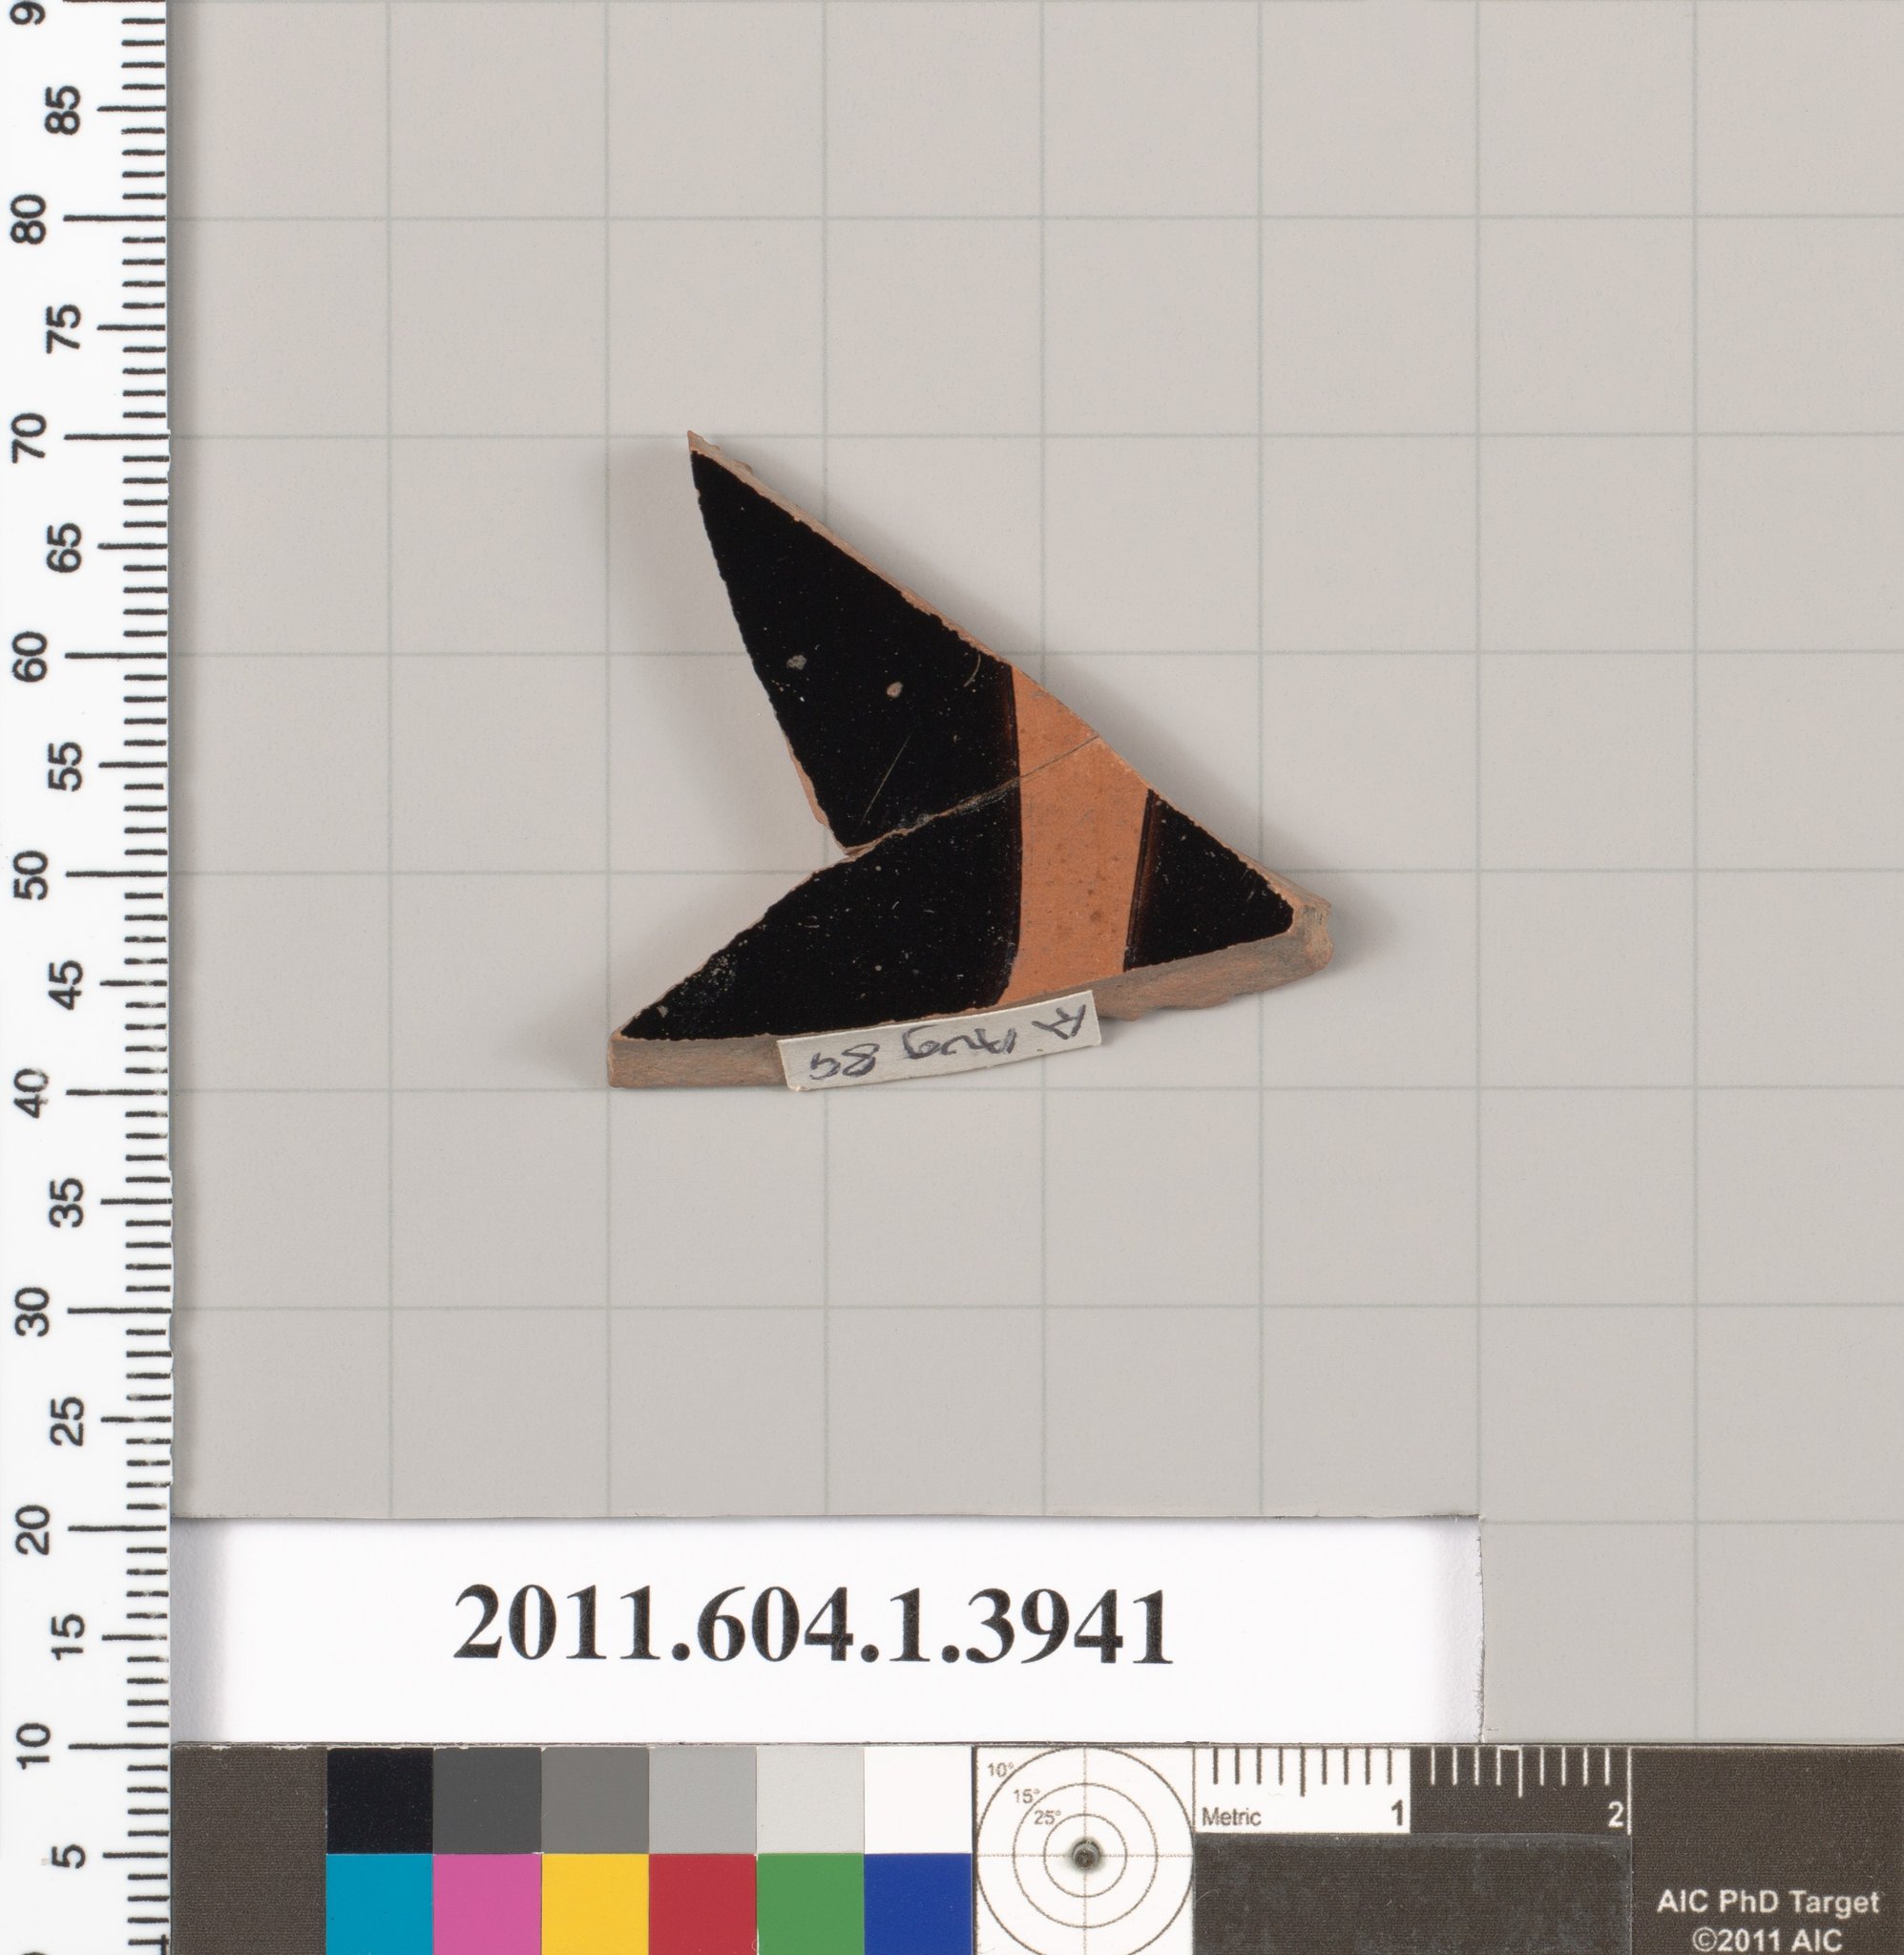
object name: kylix fragment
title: Terracotta fragment of a kylix (drinking cup)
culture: greek, attic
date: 500-476 BCE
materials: terracotta